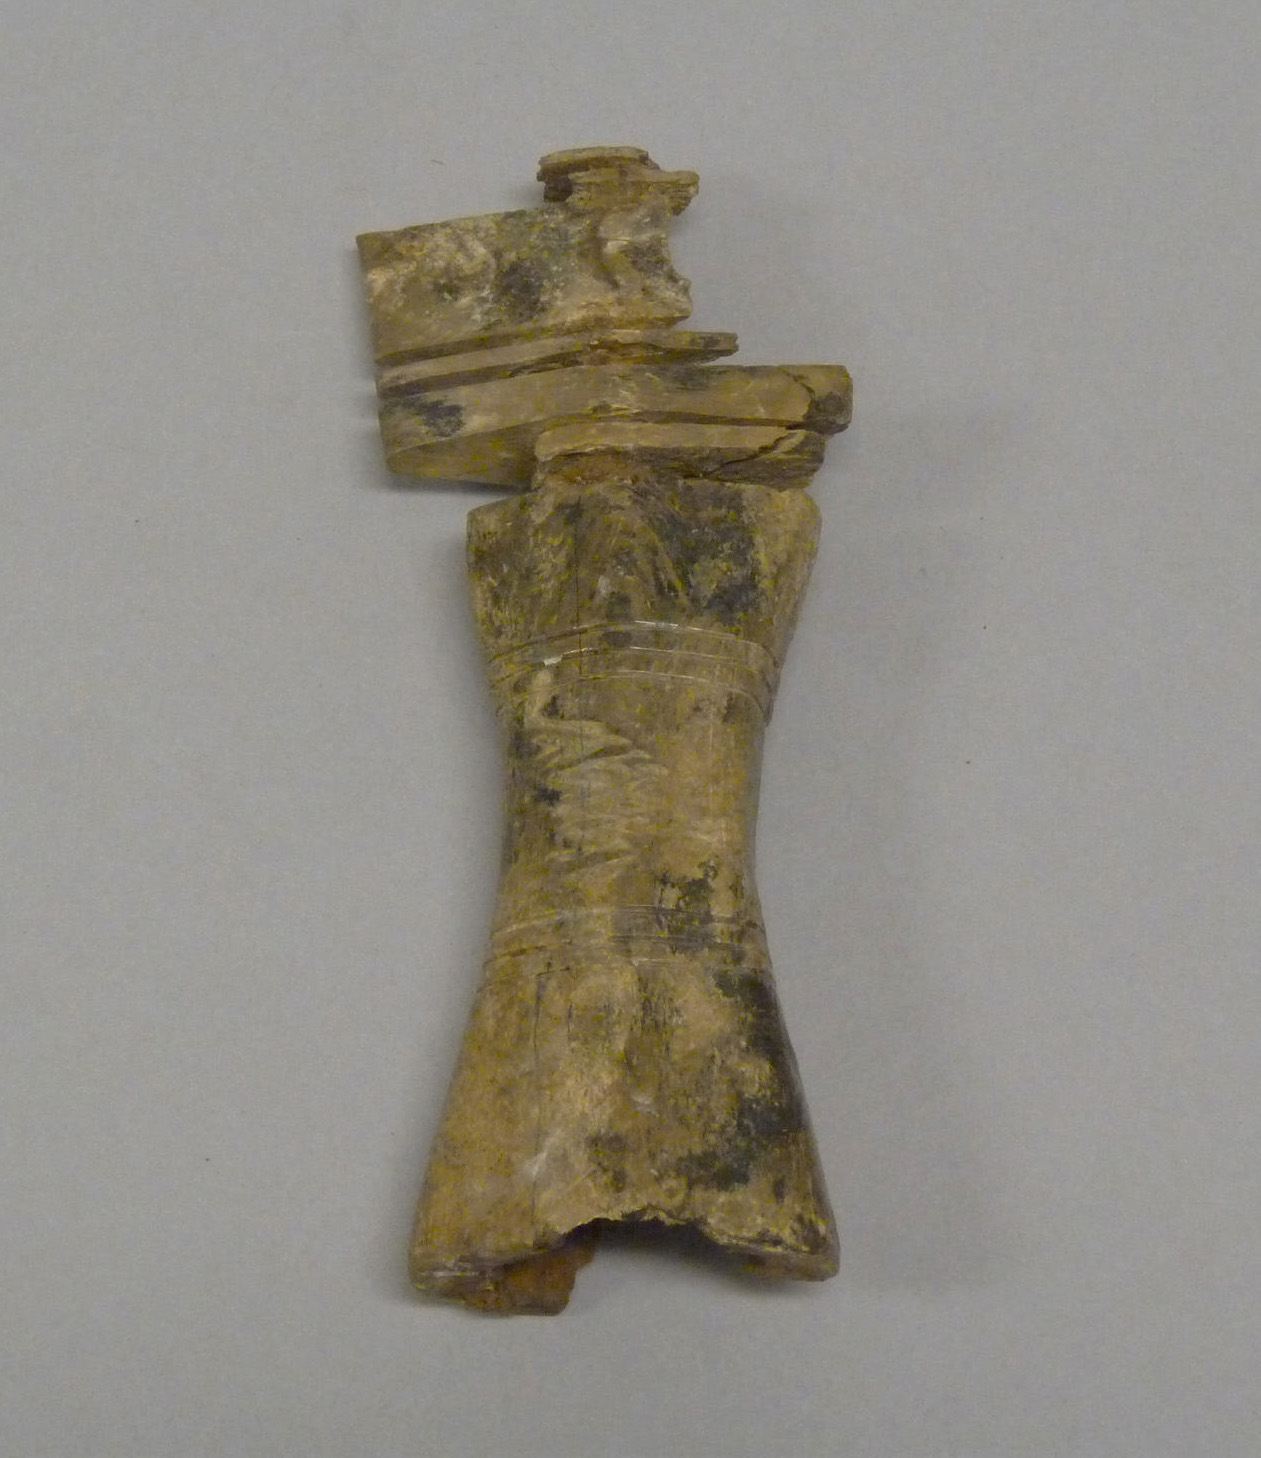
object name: knife handle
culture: indonesian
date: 500 BCE-300 CE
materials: ivory